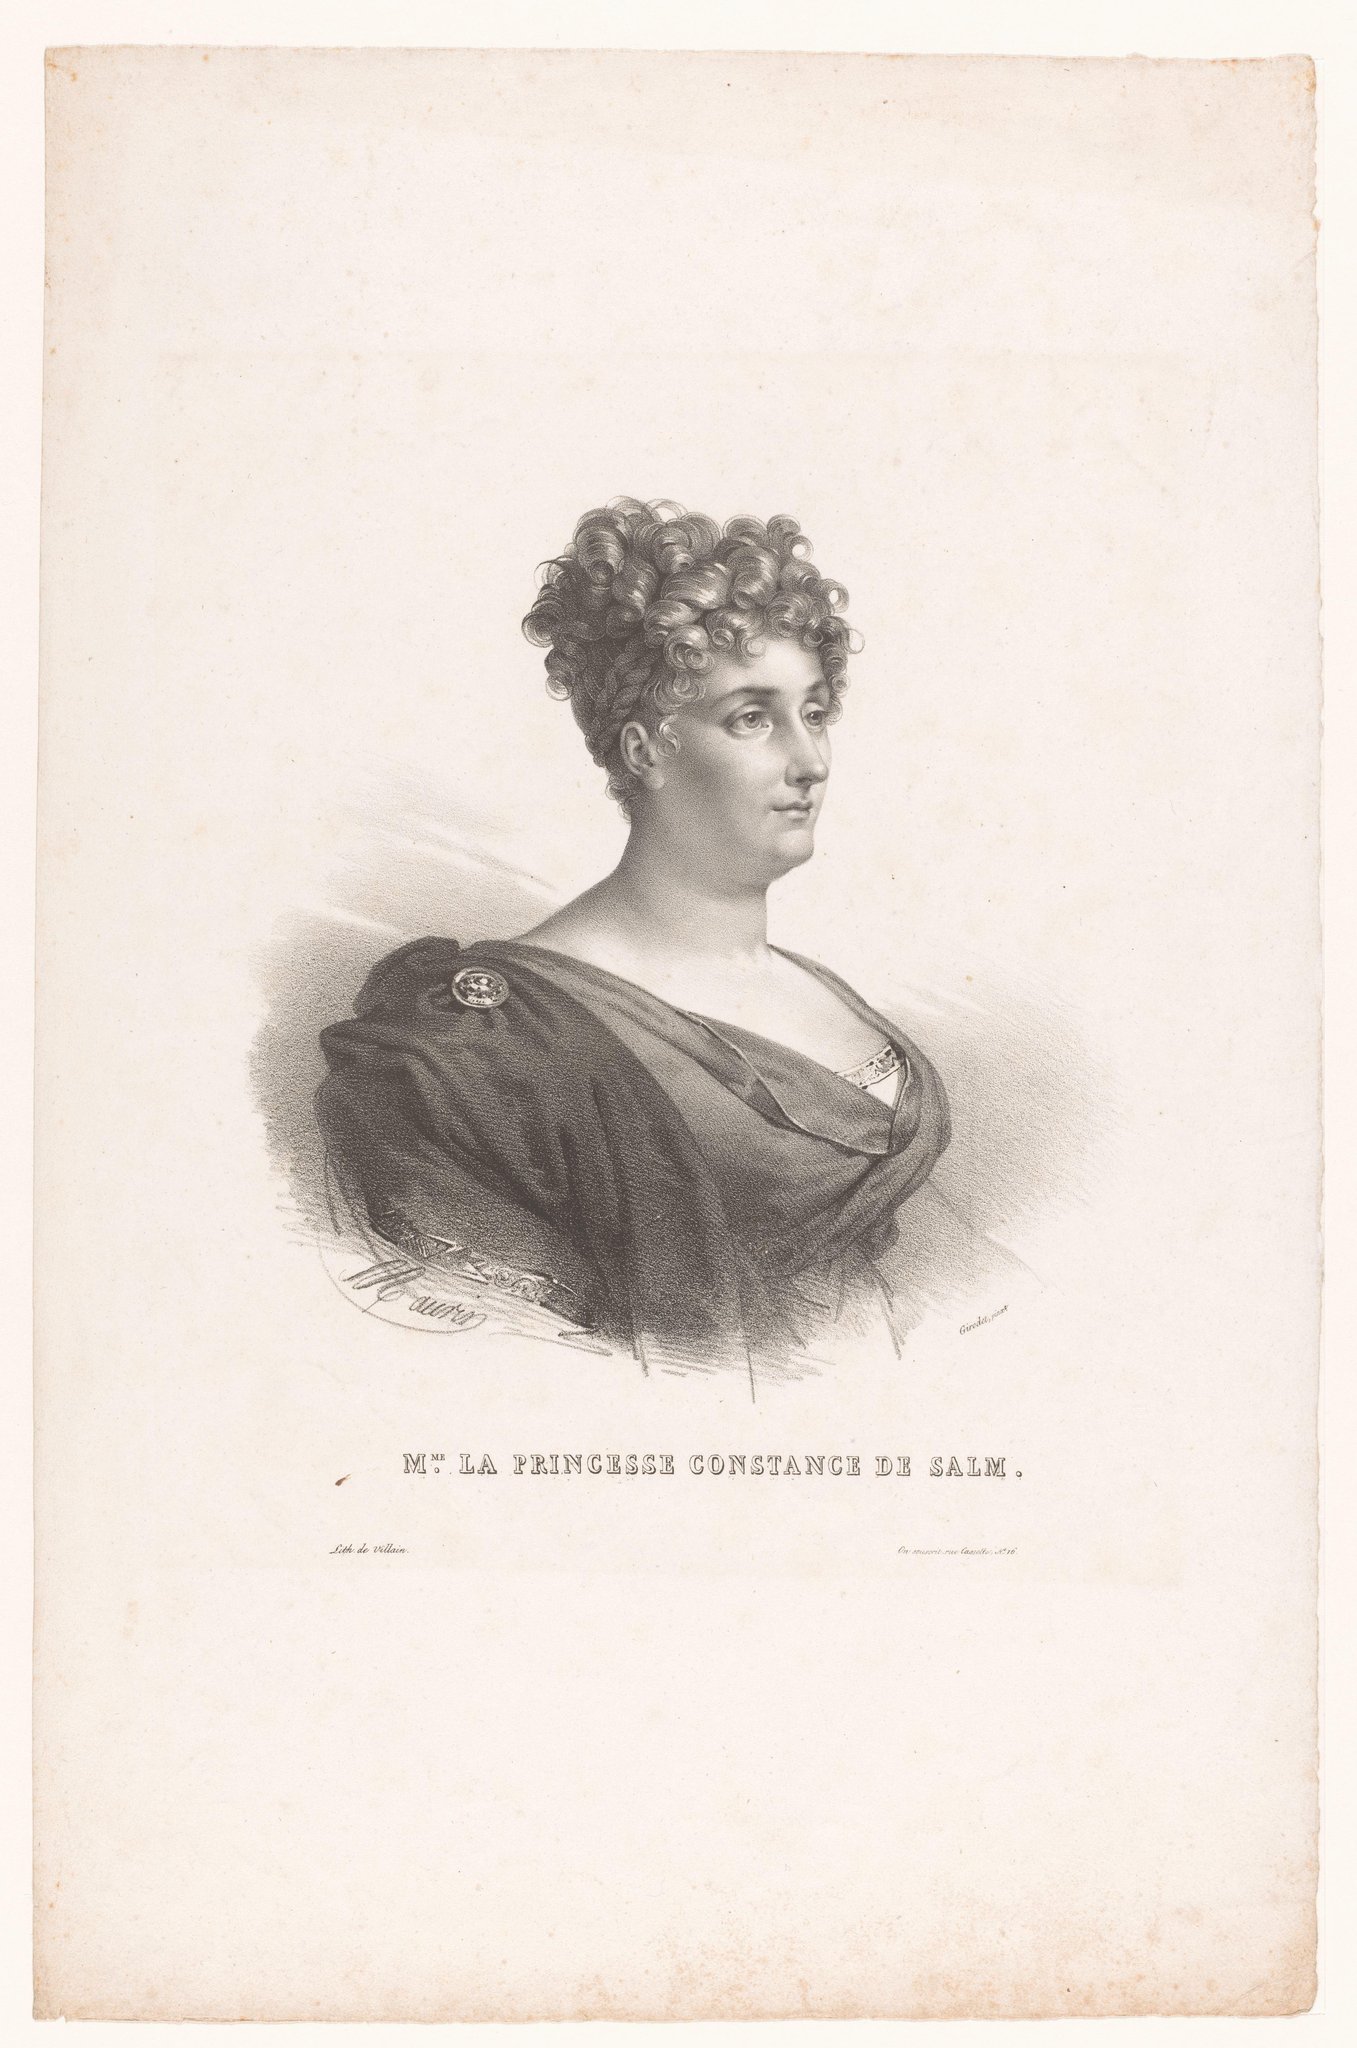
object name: print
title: Portret van Constance de Théis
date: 1826-1852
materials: paper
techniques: lithograph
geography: paris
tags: historical persons, writer, poet, author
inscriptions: check stamp: ‘JC’, collector's mark: Lugt 2228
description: Prent waarschijnlijk ook gebruikt in: Chabert, Jean Claude. Galerie des contemporaines, ou collection de portraits des femmes qui se sont rendues célèbres depuis la fin du dix-huitième siècle, en France et dans les pays étrangers. Avec des notices historiques / Galerie des contemporaines ou collection de portraits et biographies des femmes, qui se sont rendues célébres, depuis la fin du dix-huitième siècle, soit en France, soit dans les pays étrangers. Parijs: Jean Claude Chabert en Hennet fils, s.a. [1824-1827]. De samenstelling van tegenwoordig bekende en al dan niet gebonden exemplaren van deze uitgaven verschillen. Dit omdat de prenten en bijhorende stukken tekst op inschrijving en waarschijnlijk ook los verkrijgbaar waren.